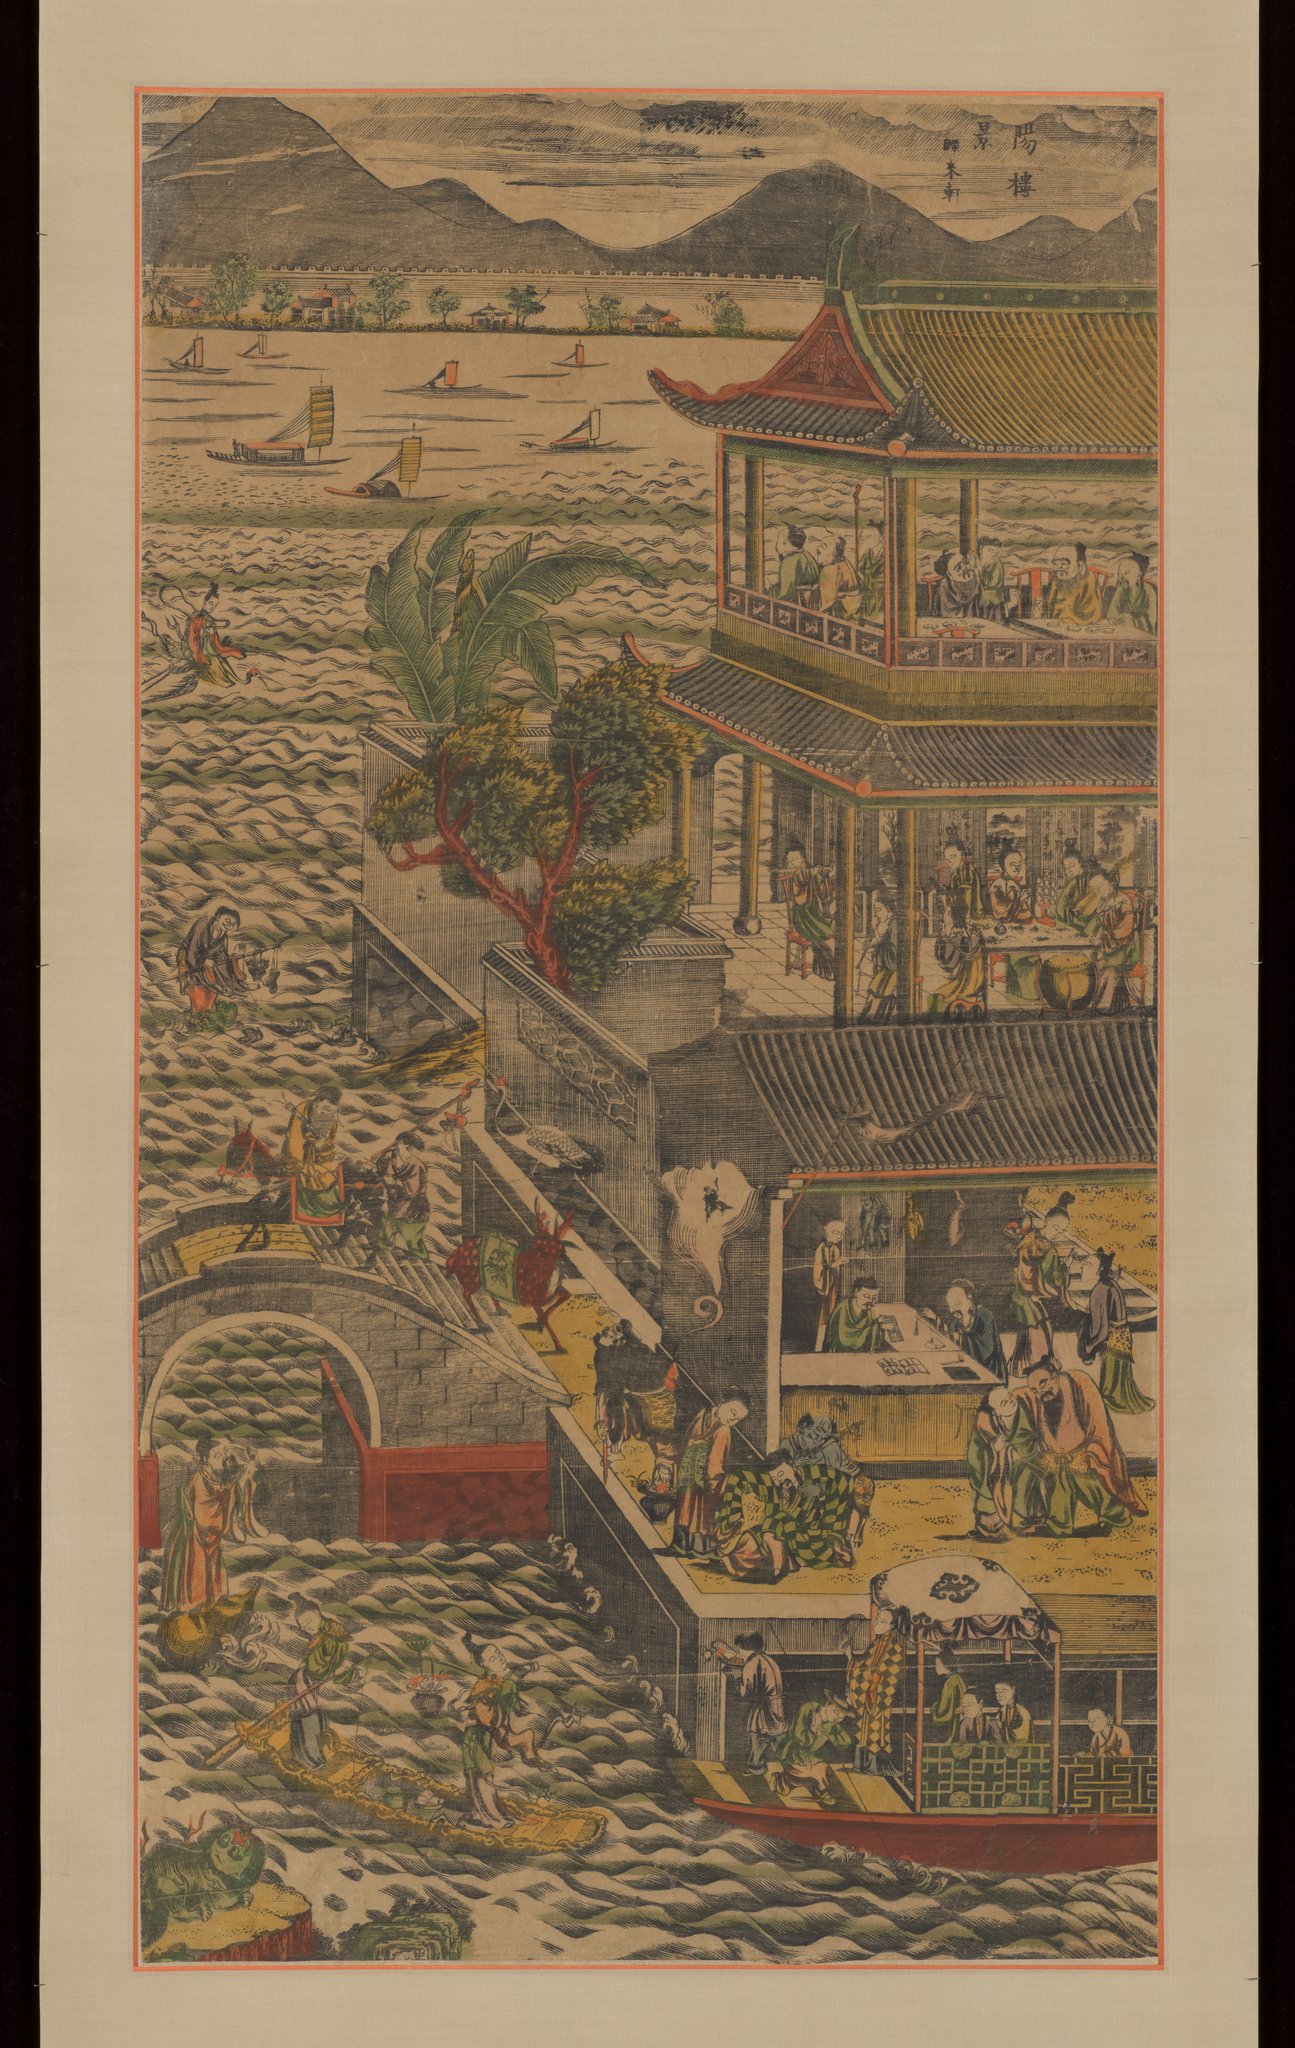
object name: print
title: Scenic View of Yueyang Tower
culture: chinese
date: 1736-1795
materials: ink, paper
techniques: hand coloring, woodblock print